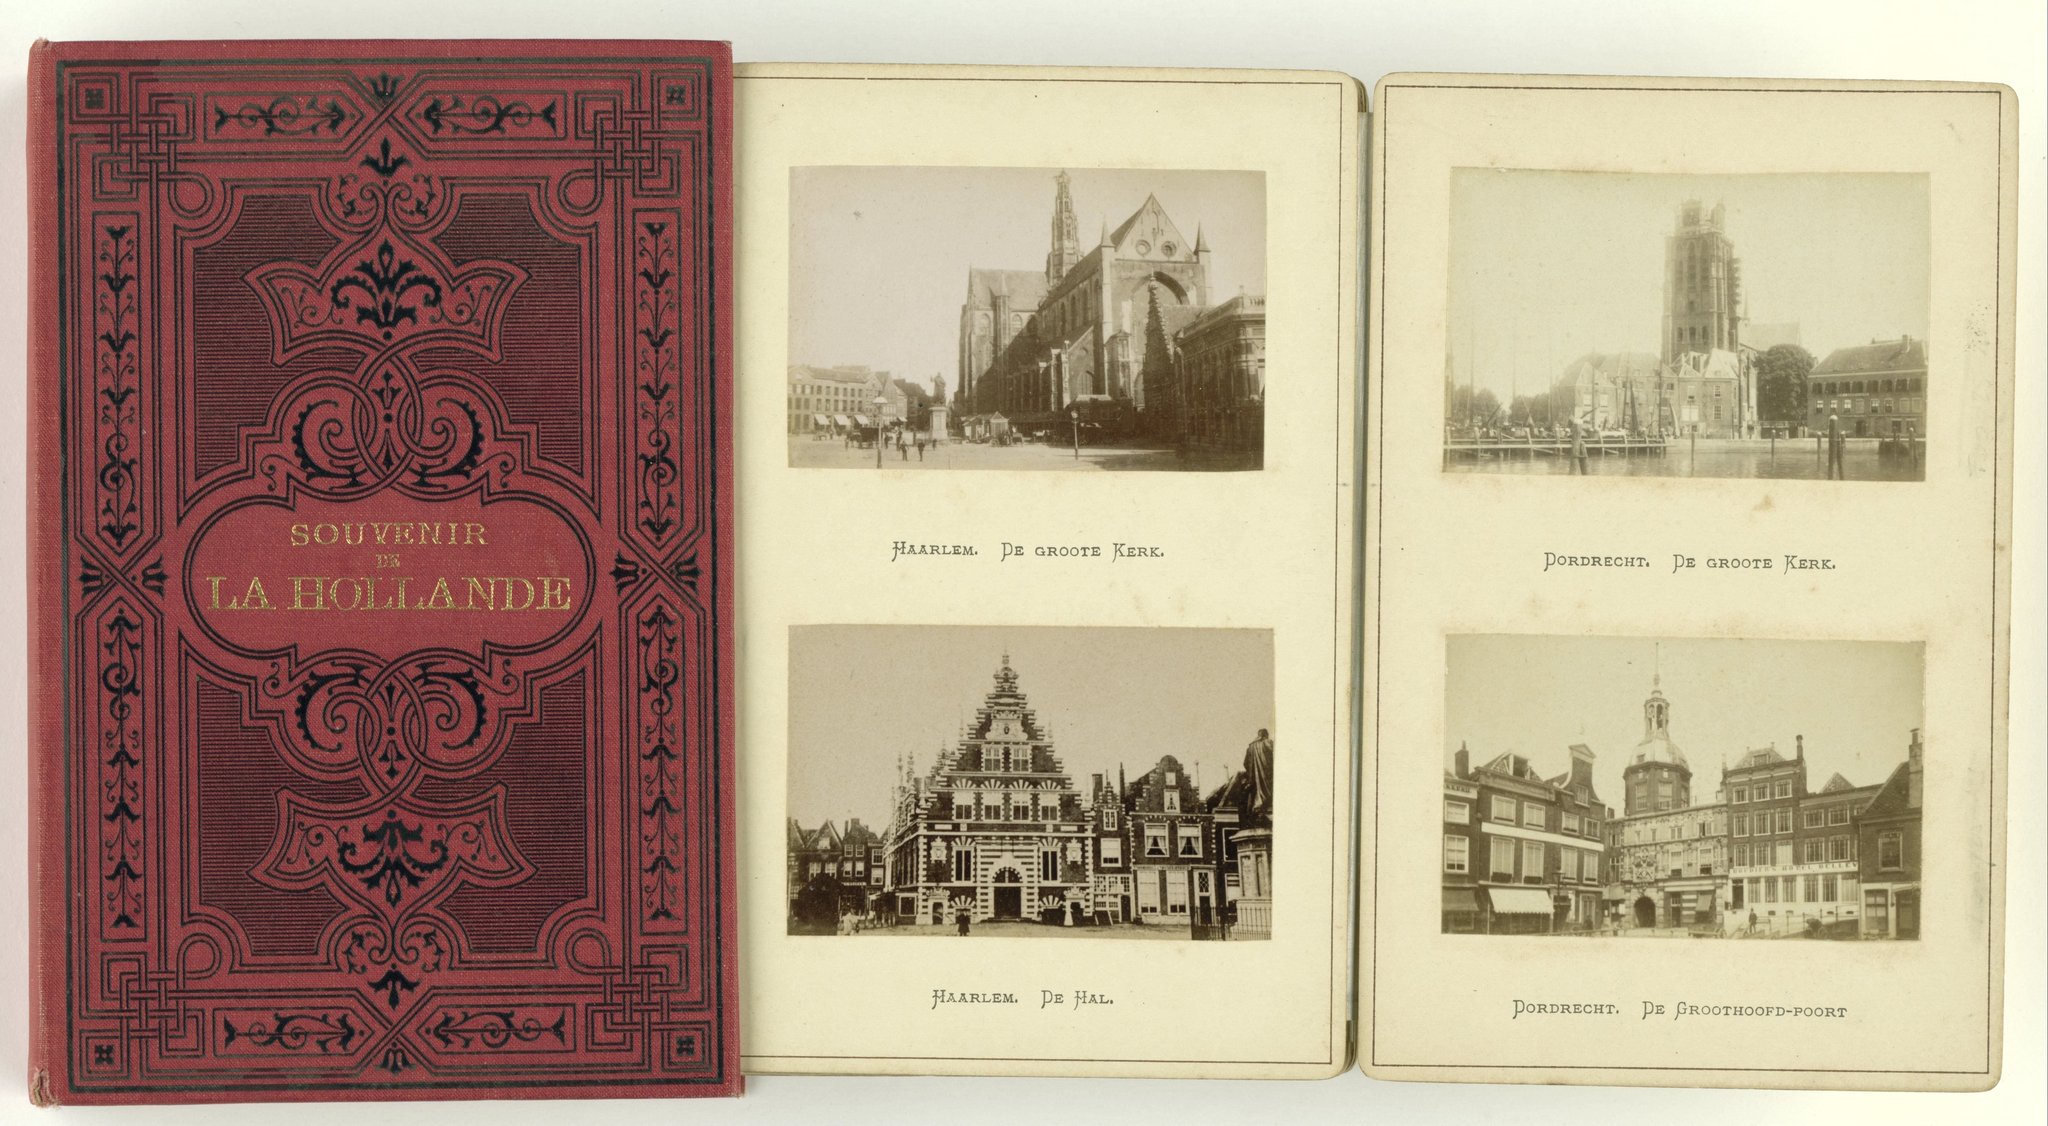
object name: photograph album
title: Fotoalbum met opnames van steden in Noord- en Zuid-Holland en Utrecht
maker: andries jager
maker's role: publisher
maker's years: 1825-1905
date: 1860-1900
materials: cardboard, linen, paper, photographic support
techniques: albumen print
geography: netherlands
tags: prospect of city, town panorama, silhouette of city, netherlands, the hague, delft, haarlem, dordrecht, rotterdam, utrecht, amsterdam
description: Leporelloalbum in rode linnen band met op de voorzijde in gouddruk de titel. Het voorplat is versierd met geometrische en plantmotieven in zwart. Het achterplat heeft eenzelfde versiering, maar dan alleen in blinddruk. Het album bevat 24 aan elkaar vastzittende, uitklapbare kartonnen bladen met daarop in totaal 48 foto's. Elk blad heeft 2 foto's die voorzien zijn van gedrukte onderschriften. Het zijn opnames van stadsgezichten in Amsterdam, Den Haag, Rotterdam, Delft, Utrecht, Haarlem en Dordrecht, alsmede enkele strandgezichten in Scheveningen.